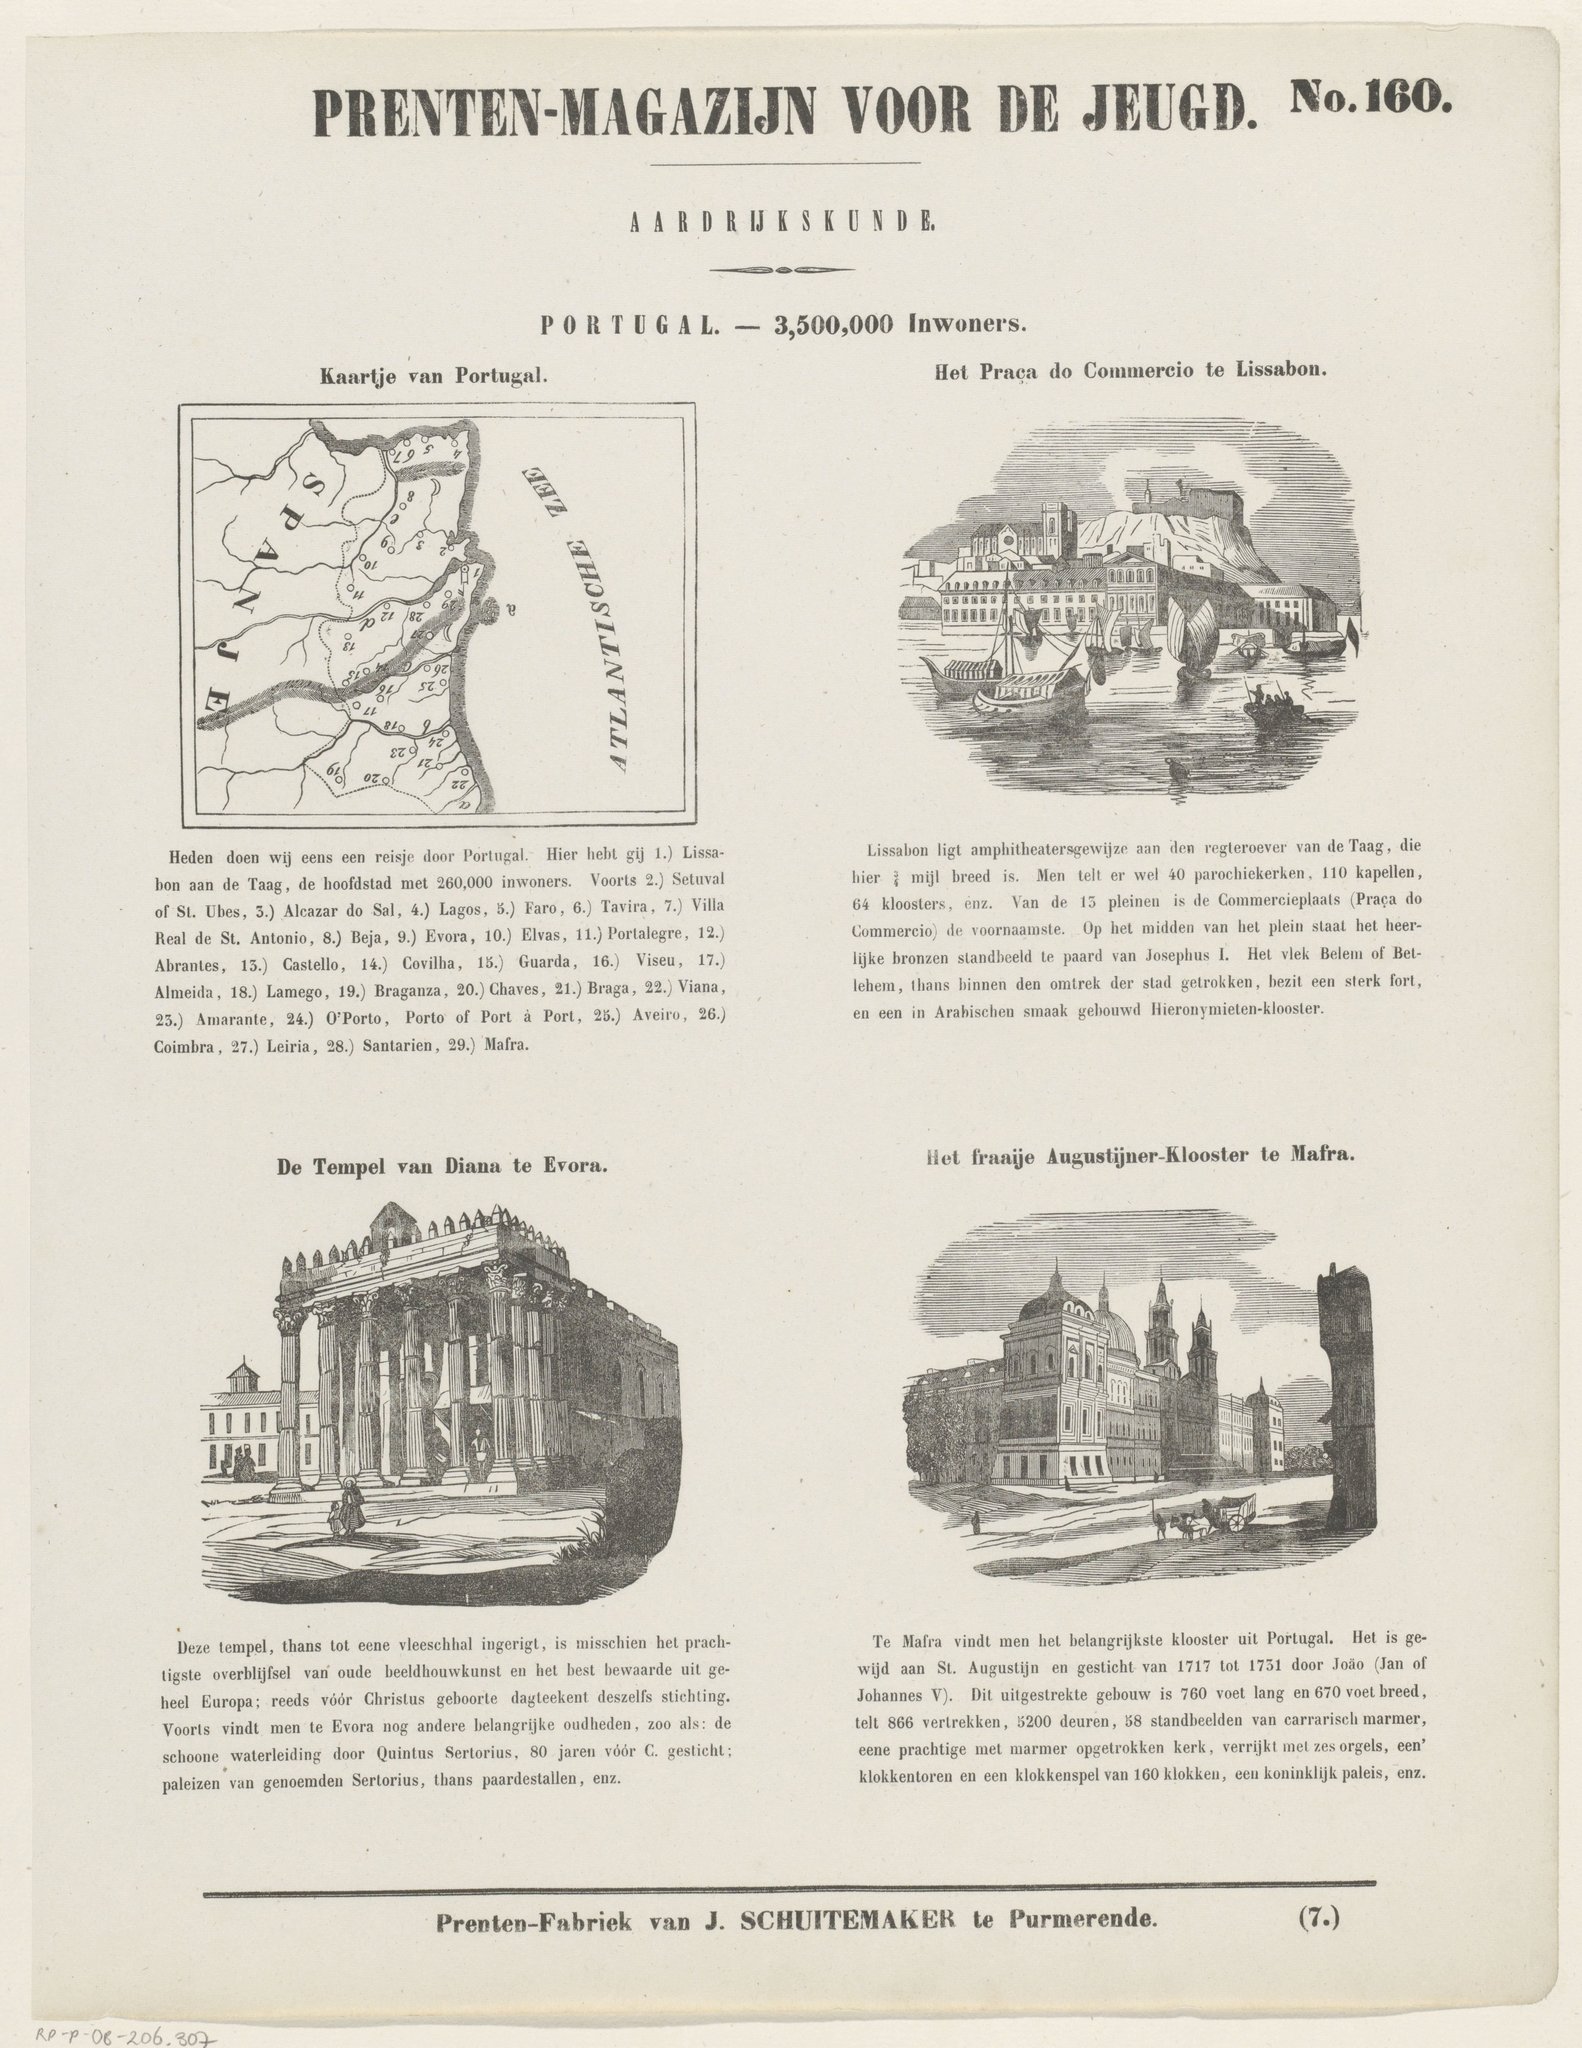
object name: print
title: Aardrijkskunde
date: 1850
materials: paper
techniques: letterpress printing, engraving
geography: netherlands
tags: maps, atlases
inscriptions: collector's mark: Lugt 2760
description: Na voltooiing van de acht jaargangen van de reeks 'Prenten-magazijn voor de jeugd' in 1850 heeft Jan Schuitemaker al deze prenten heruitgegeven en omgenummerd als nr. 1 t/m 192. De oorspronkelijke jaargang wordt telkens nog vermeld rechtsonder op de prent. Binnen de jaargangen zijn prenten van hetzelfde thema in clusters van vier achter elkaar gezet.